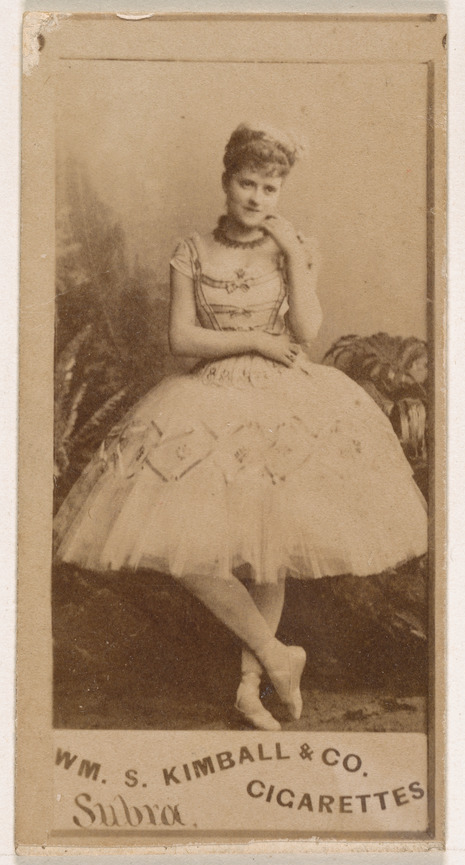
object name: photograph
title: Miss Subra, from the Actresses series (N203) issued by Wm. S. Kimball & Co.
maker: william s. kimball & company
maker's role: publisher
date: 1889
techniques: color lithograph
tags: portraits,women,actresses